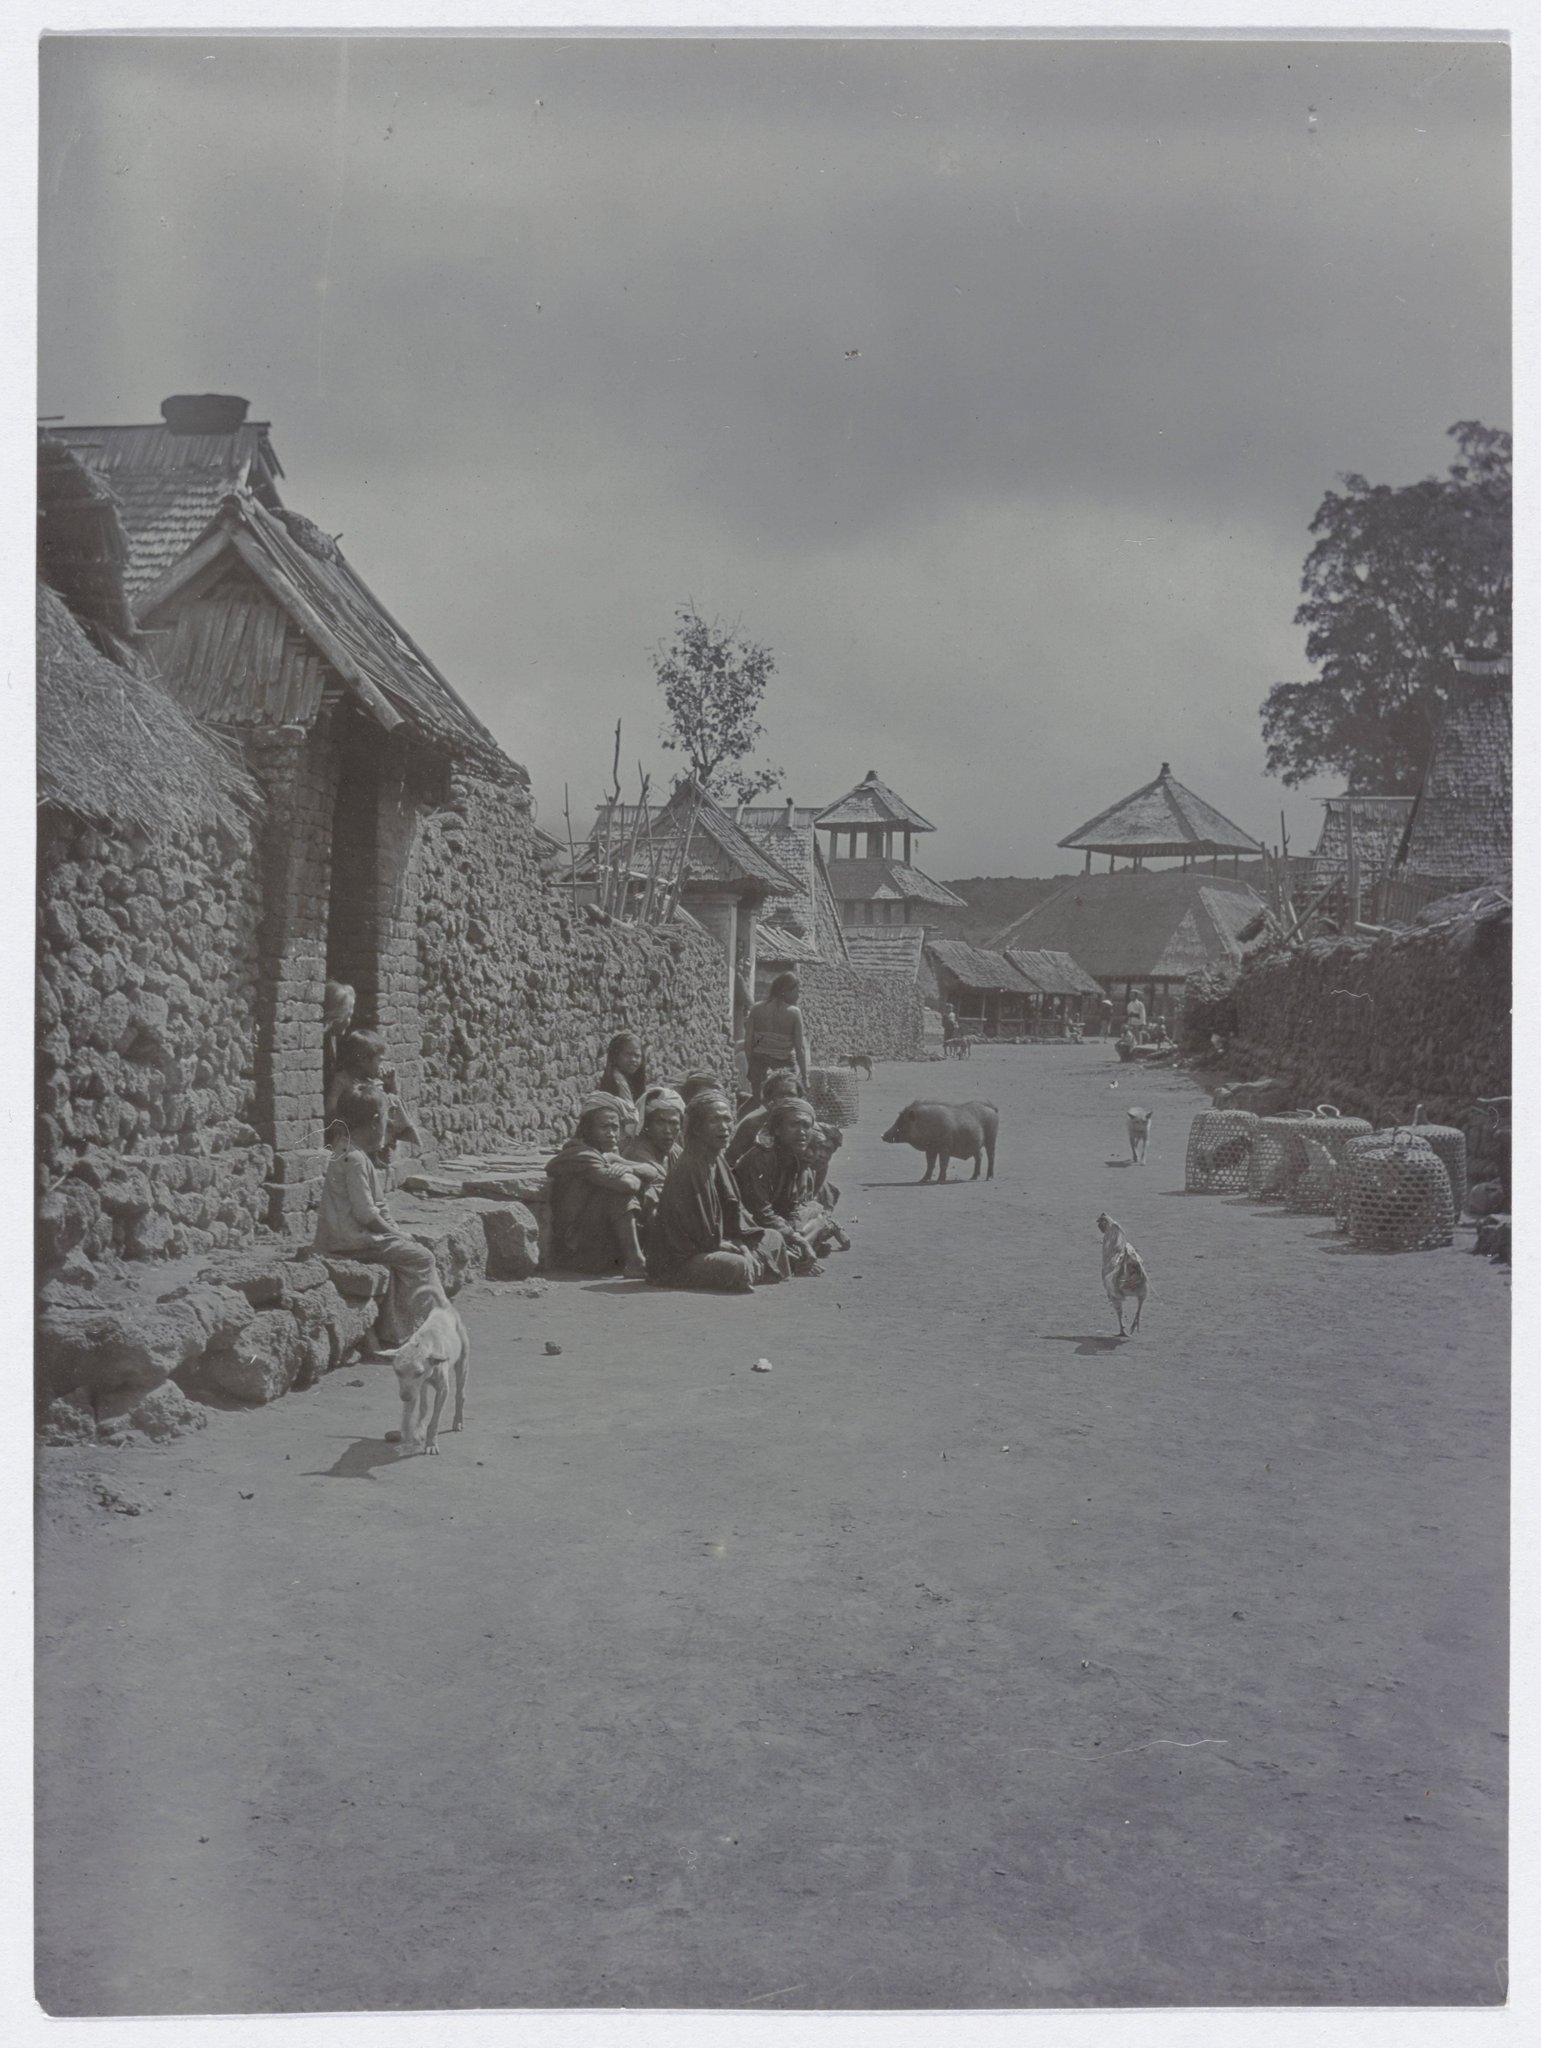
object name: photograph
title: 12 en 13 Midden-Bali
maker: johanna hermina marmelstein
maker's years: 1897-1990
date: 1900-1915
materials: paper, photographic support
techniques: albumen print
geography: jakarta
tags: bali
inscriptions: annotation: ‘12 en 13 Midden-Bali. Dorpsstraat v/d kampong Batoer met het Balische huisdier = varken en de zoo populaire vechthanen op den voorgrond. Wat het groepje mannen deed, is onbekend. Op de achtergrond koelkoel (midden links) en het balineesch stadion voor de hanengevechten (in elk dorp van beteekenis te vinden) in het midden rechts. Dichtbij is gelegen de nog werkende vuurspuwende berg Batoer.’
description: Een straatgezicht in het dorp Batur.Met op de voorgrond een groep mannen zittend op straat, aan de andere kant van de weg staan vechthanen onder manden zodat ze niet weg kunnen. Op straat lopen tevens varkens en honden. Op de achtergrond is de arena waar de vechthanen ter vermaak en weddenschap hun strijd uitvechten zichtbaar.